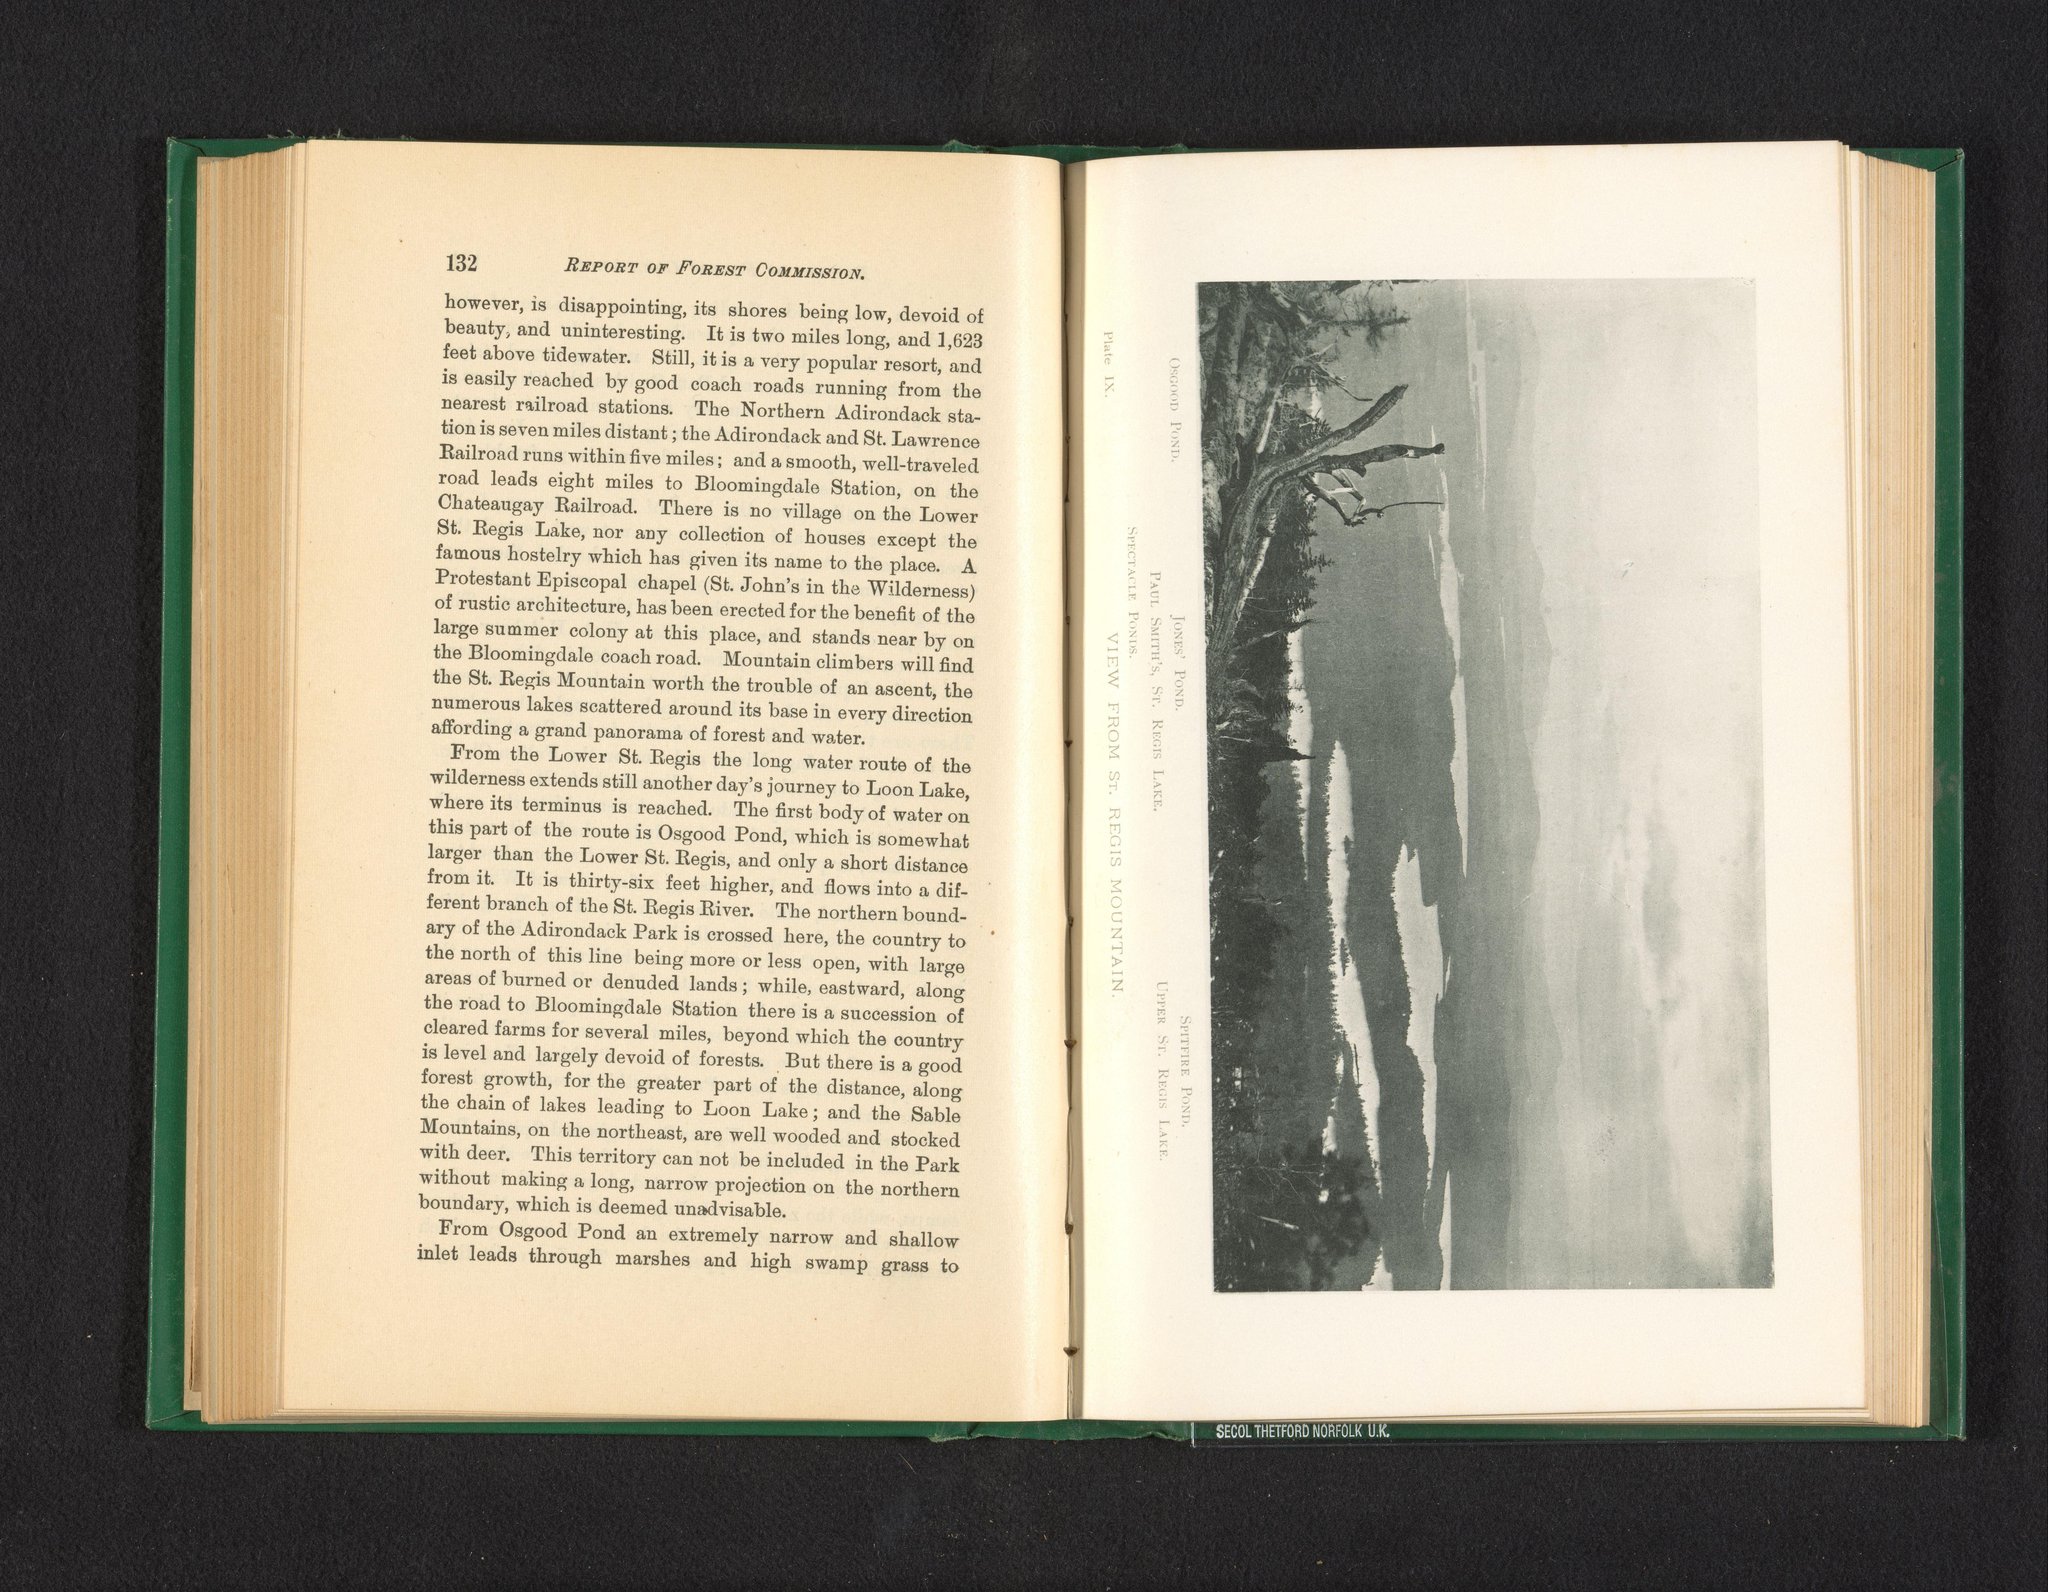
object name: photomechanical print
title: View from St. Regis Mountain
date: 1891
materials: paper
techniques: photograph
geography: saint regis mountain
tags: landscapes with waters, waterscapes, seascapes (in the temperate zone)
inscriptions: inscription: ‘Osgood Pond (...) Upper St. Regis Lake’, number: ‘Plate IX.’